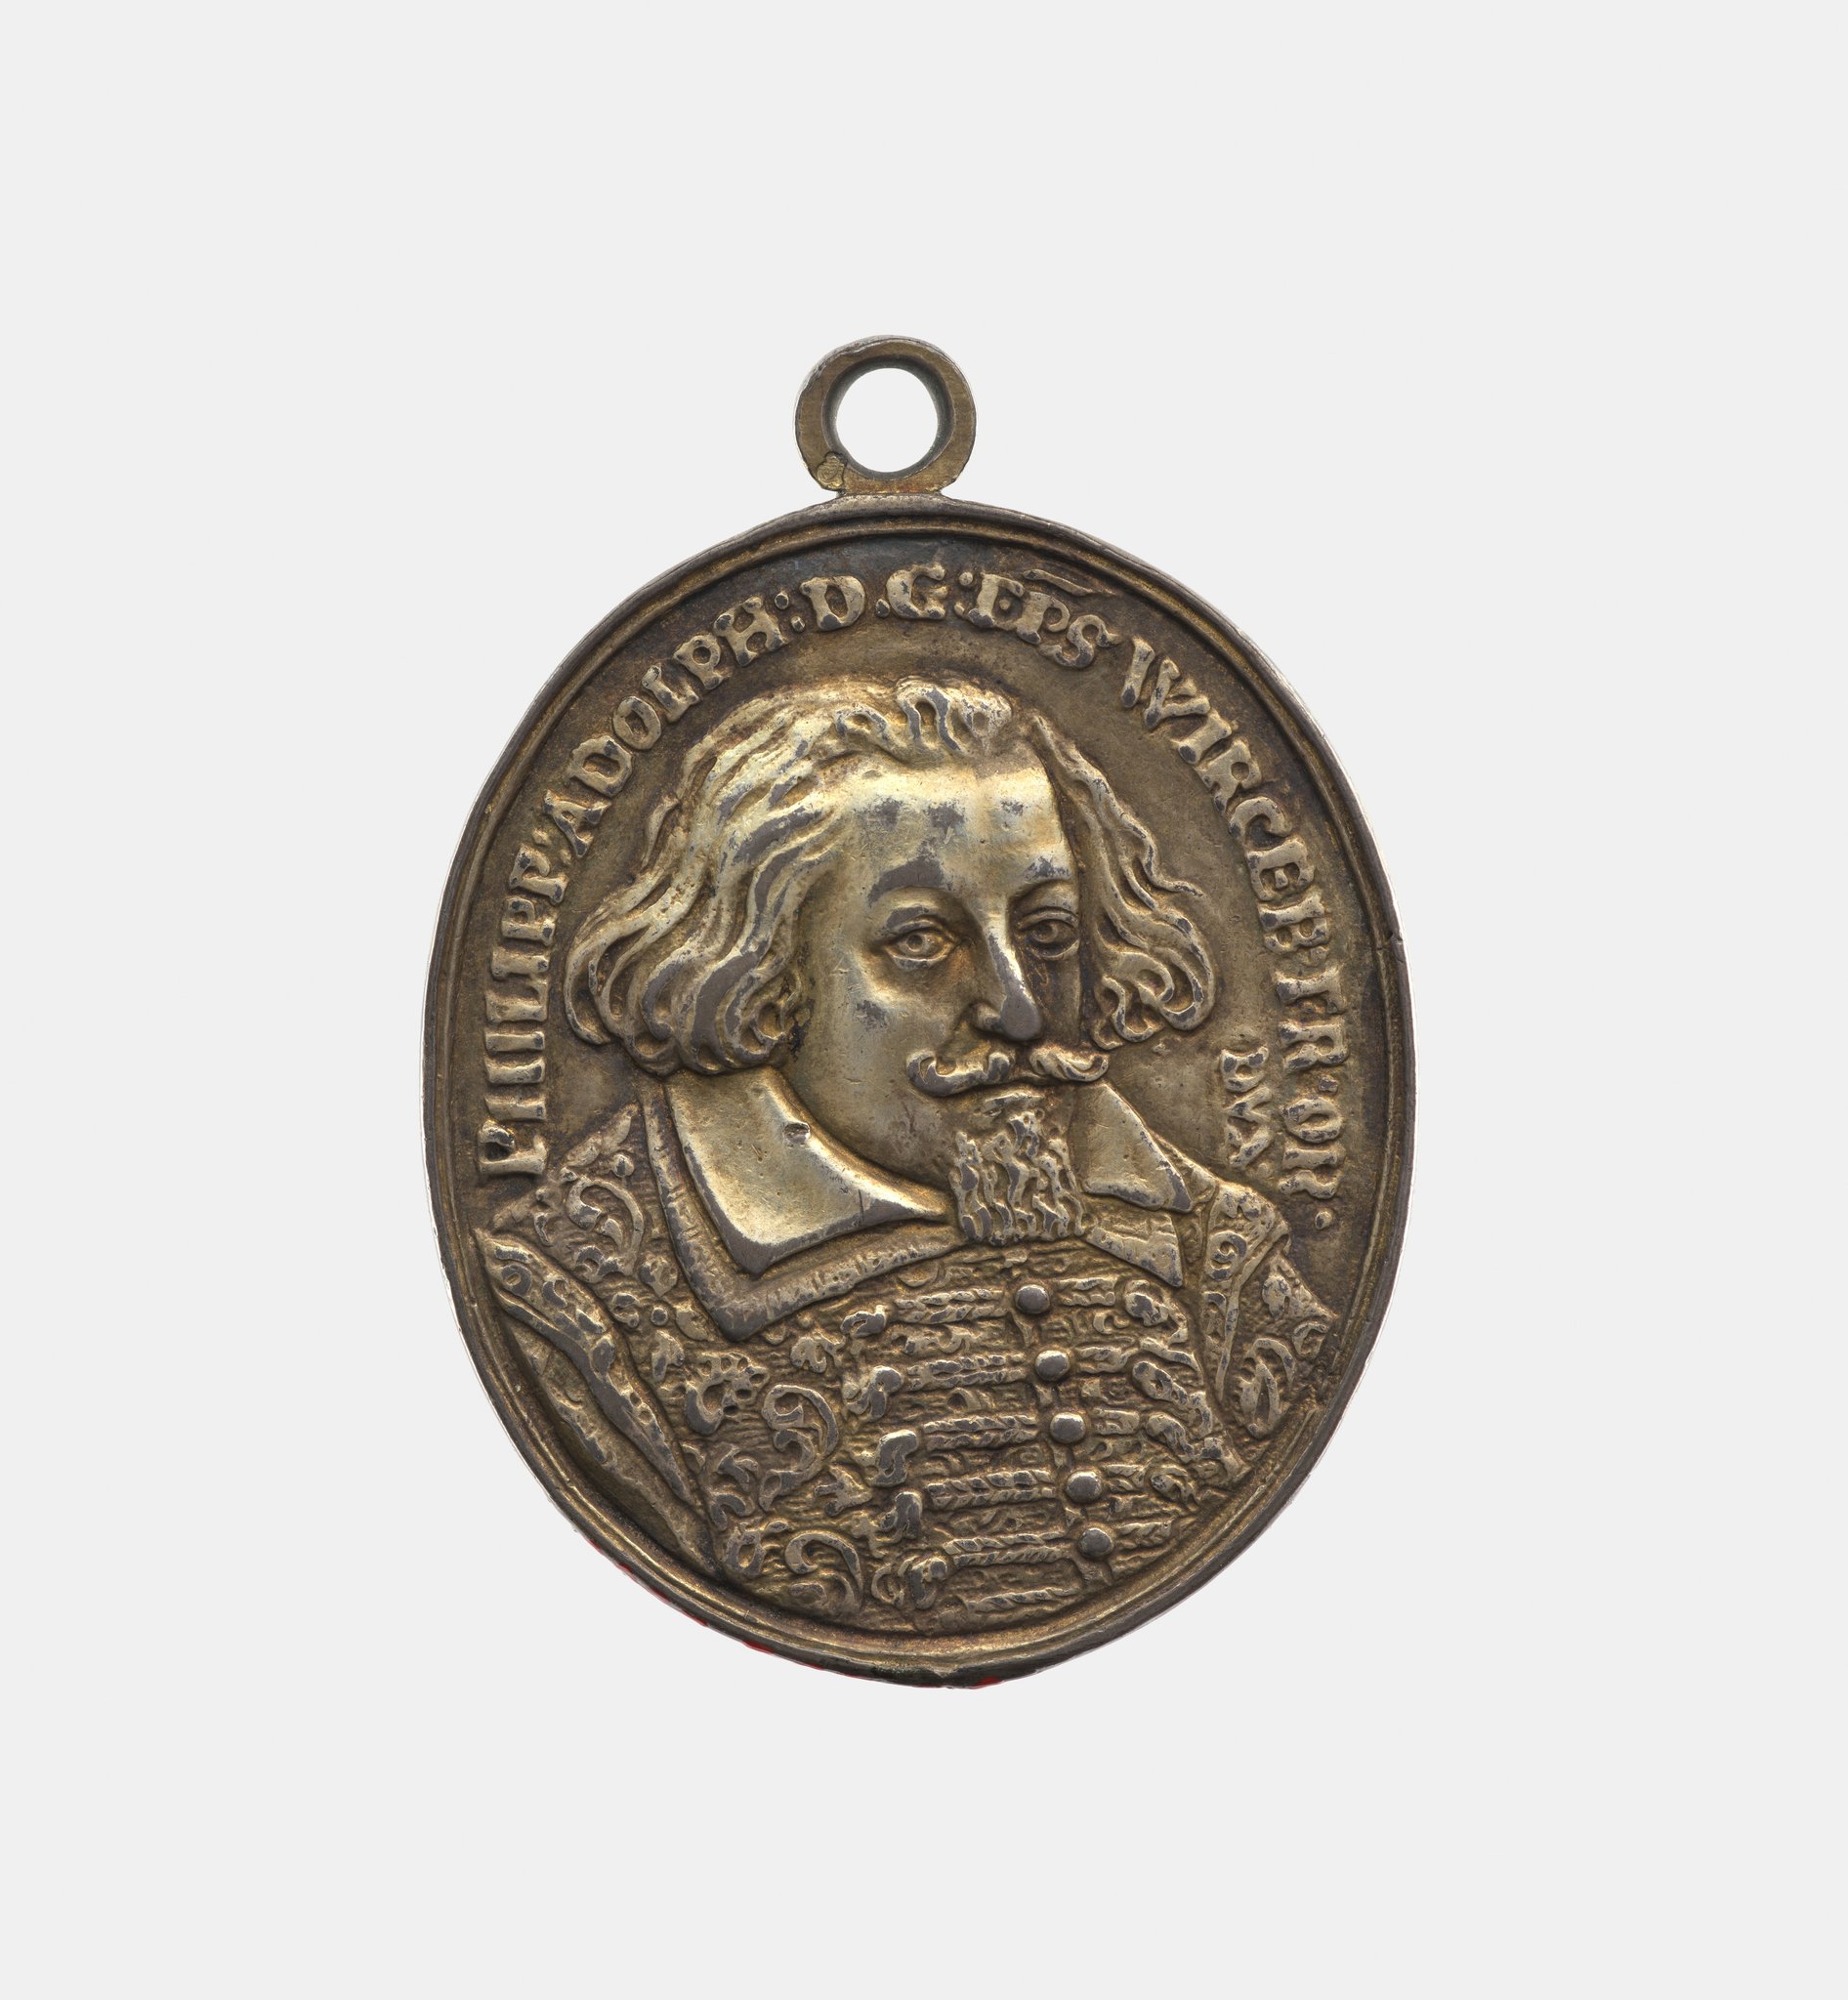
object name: medal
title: Philipp Adolf von Ehrenberg, Bishop of Würzburg 1623-31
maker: georg holdermann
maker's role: artist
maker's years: 1585-1629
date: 1623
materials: silver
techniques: gilding